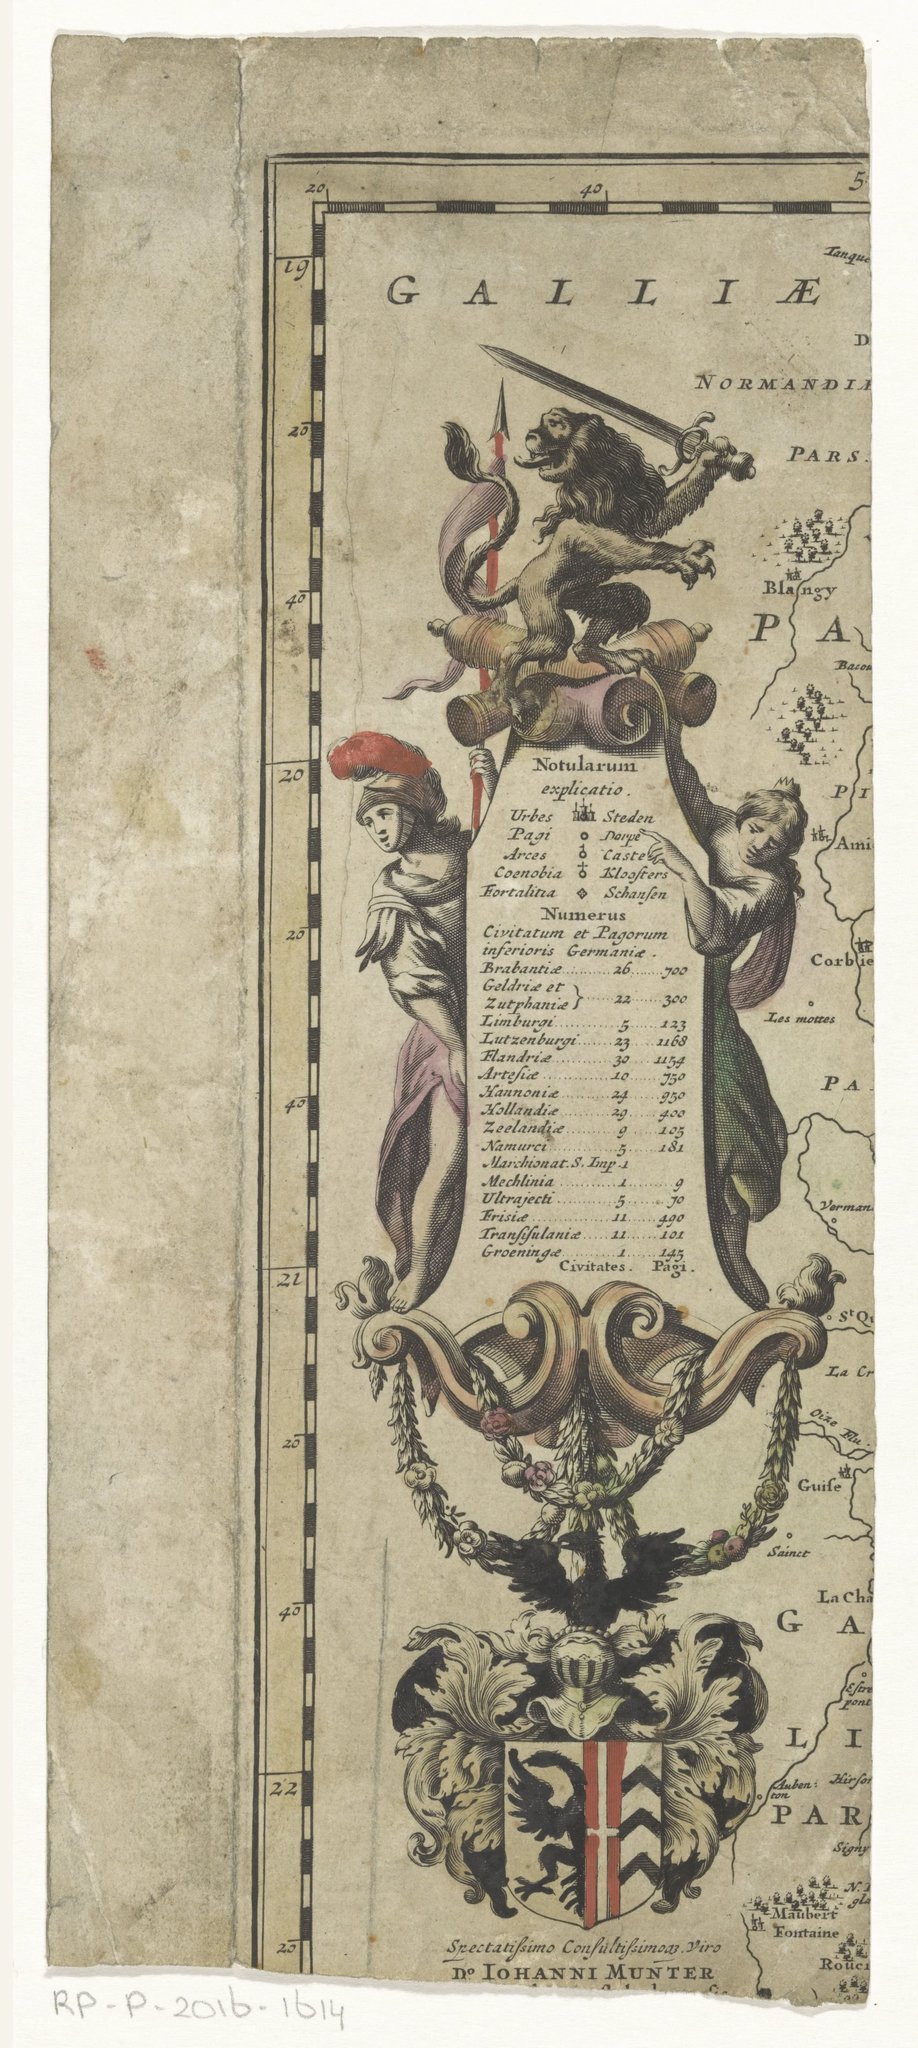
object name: print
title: Galliae (...)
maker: Anonymous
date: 1650-1750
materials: paper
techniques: engraving, hand coloring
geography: netherlands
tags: ruler, sovereign - bb - female ruler, the soldier; the soldier's life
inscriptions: collector's mark: Lugt 2228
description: Notularum explicatio (verklaring) geflankeerd door een soldaat en een vrouw met kroon. Aan de bovenzijde staat een leeuw met zwaard op kanonnen. Aan de onderzijde guirlandes en een wapenschild. Detail van een kaart van Gallië.